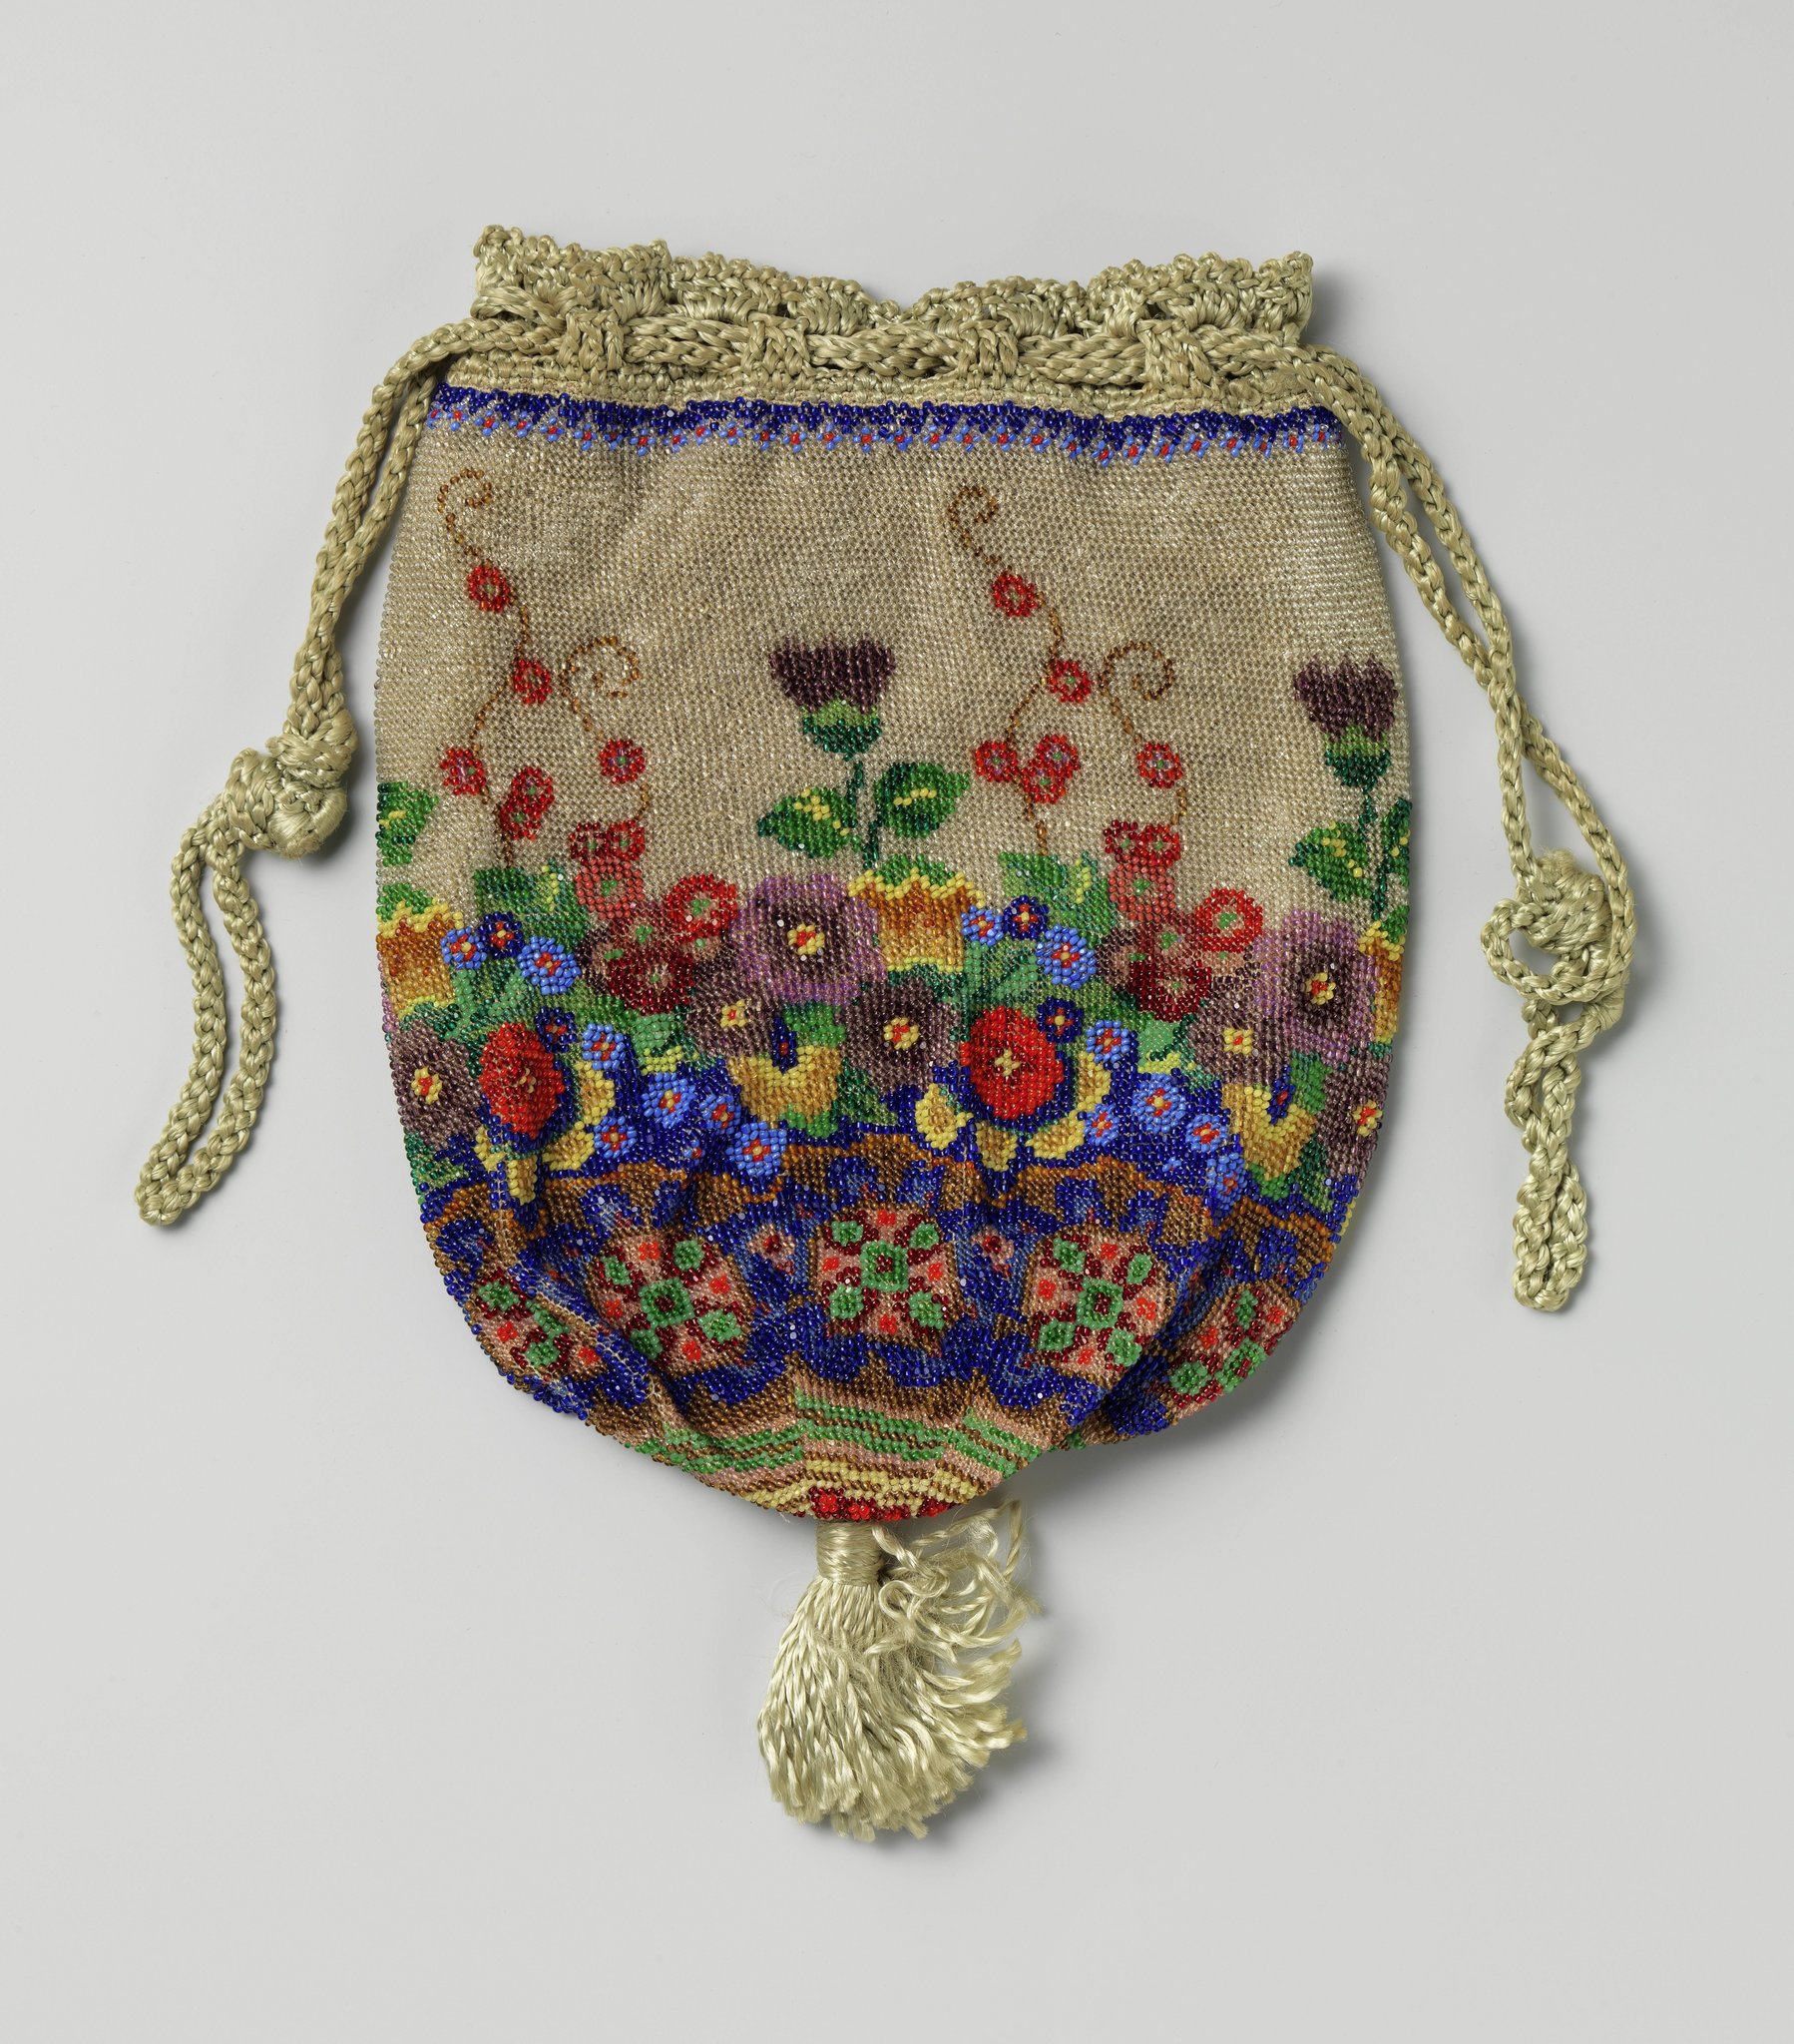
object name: purse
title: Buidel, geweven met een patroon van veelkleurige bloemen van kralen, voorzien van een zijden trekkoord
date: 1920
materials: glass, silk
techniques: braiding, glassblowing, weave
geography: vienna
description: Buidel, geheel geweven met een patroon van veelkleurige bloemen van kralen: vanaf de onderkant cirkels, waarna een blauwe band met groene en roze bloemen, waarboven een diversiteit aan bloemen in blauw, geel, rood en paars. Vanaf het midden een overwegend wit fond, met een enkele uitstekende paarse of rode bloem. Door de gehaakte bovenkant is een zijden trekkoord geregen. De buidel is gevoerd met zijde.